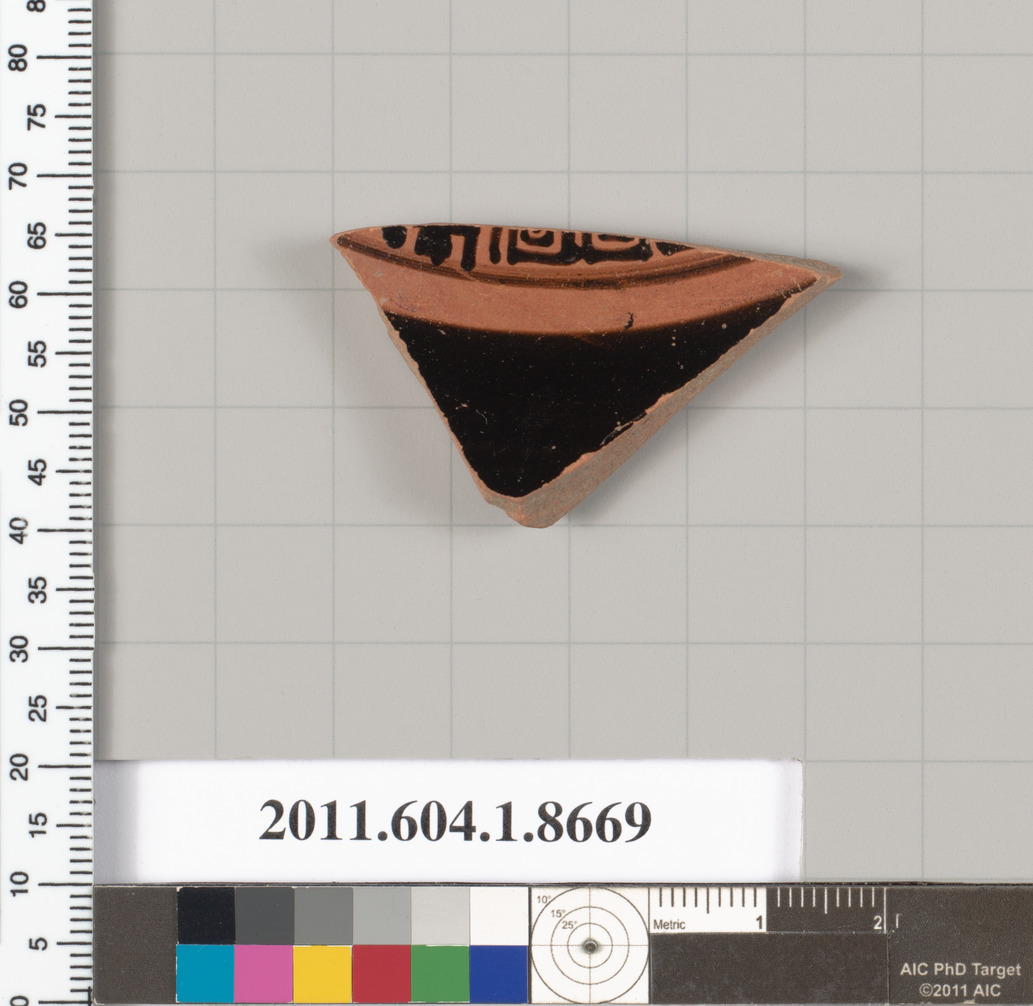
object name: kylix fragment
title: Terracotta fragment of a stemless kylix (drinking cup)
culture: greek, attic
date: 460-450 BCE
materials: terracotta